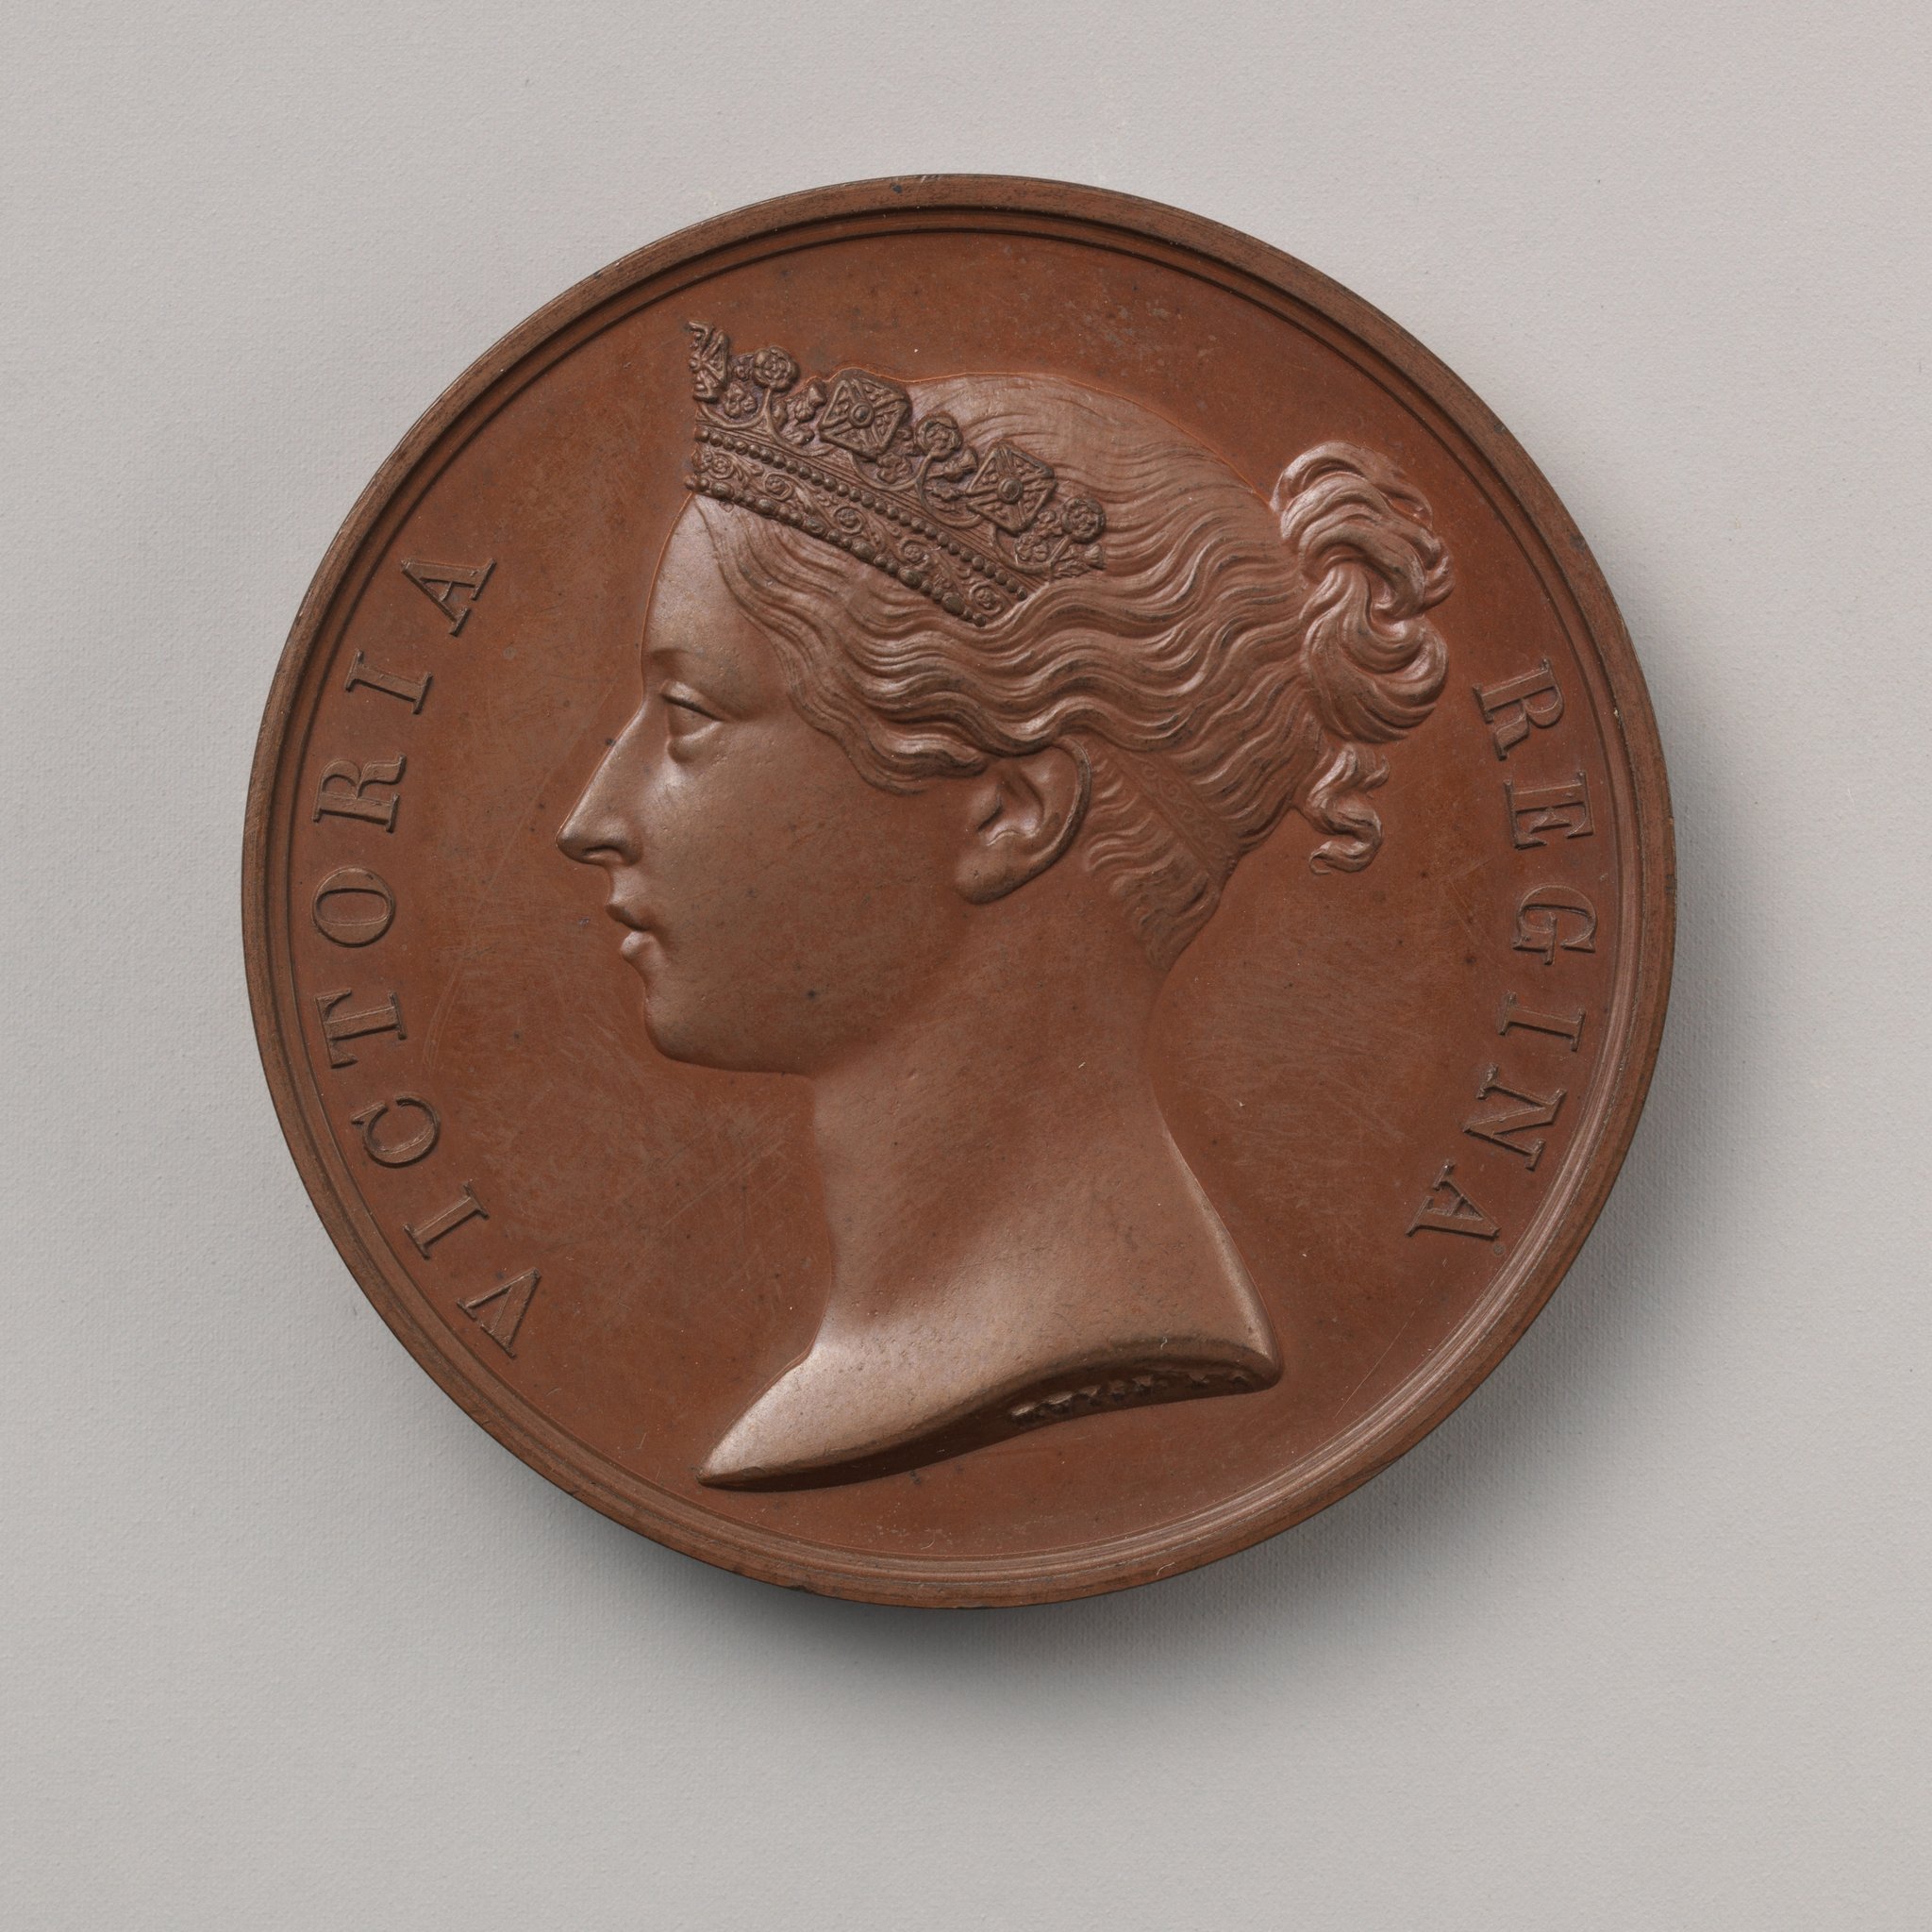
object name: medal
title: The Sutlej Medal (1845–46)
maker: william wyon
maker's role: artist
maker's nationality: british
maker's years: 1795-1851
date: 1846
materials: bronze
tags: profiles